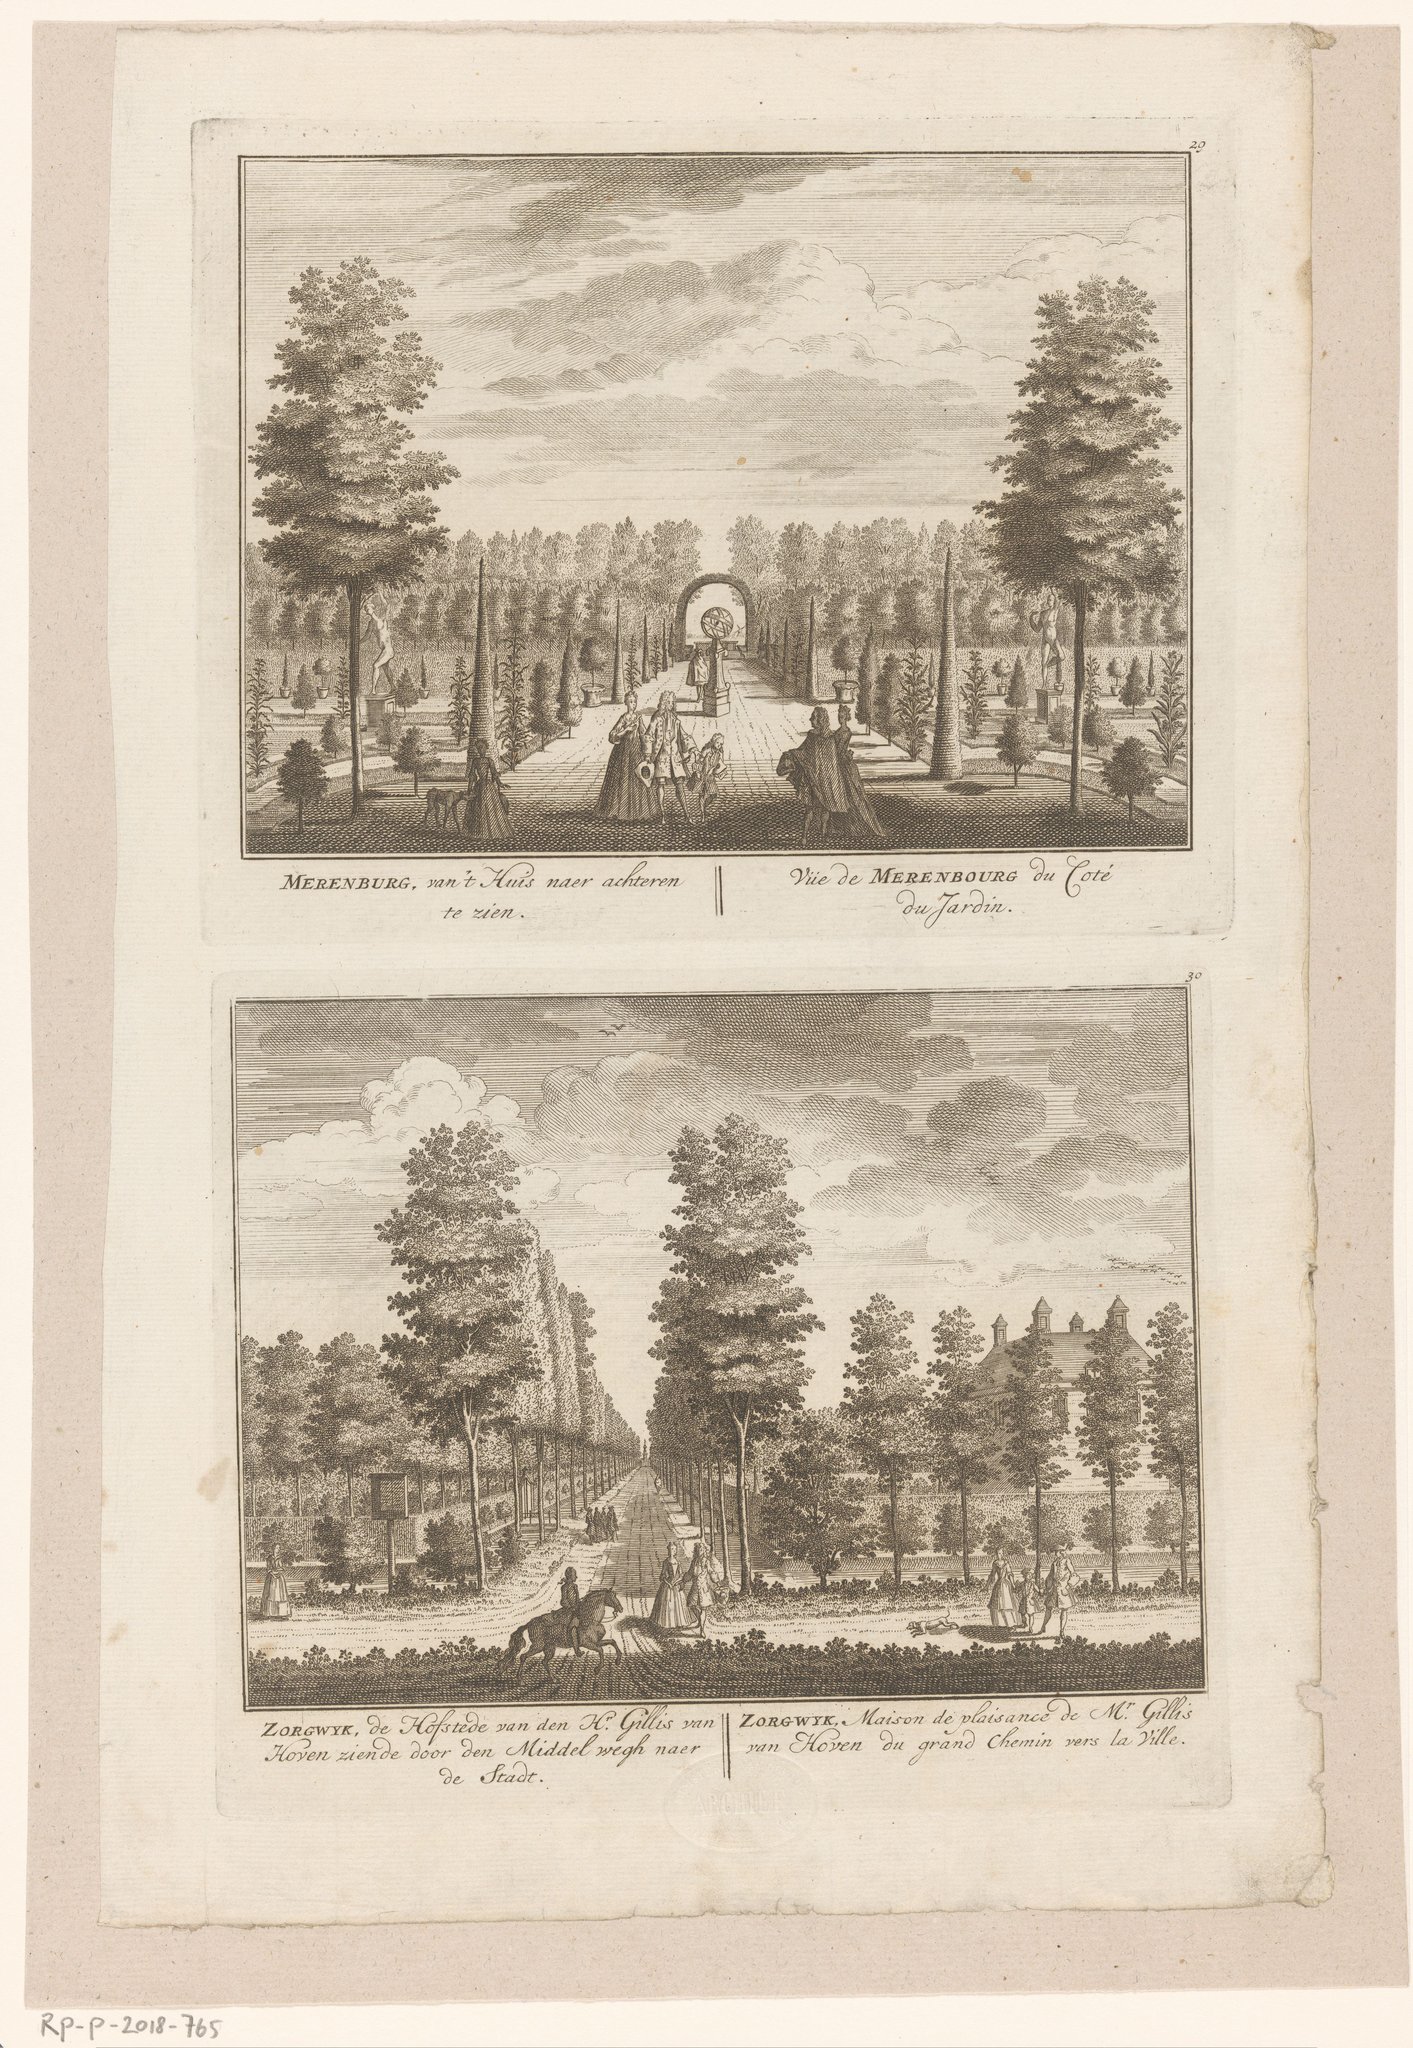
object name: book illustration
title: Merenburg, van 't huis naer achteren te zien / Vüe de Merenbourg du coté du jardin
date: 1725-1768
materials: paper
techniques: engraving, etching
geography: amsterdam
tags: french or architectonic garden; formal garden, public road, country-house, amsterdam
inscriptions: check stamp: ‘Archief Ministerie van Oorlog Afdeeling Genie’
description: Prent gebruikt in: Niedek, Mattaeus Brouërius. Het verheerlykt Watergraafs- of Diemermeer by de stadt Amsterdam (...). Amsterdam: Andries en Hendrik de Leth, 1725. Of in: Niedek, Mattaeus Brouërius. Het verheerlykt Watergraafs- of Diemermeer by de stadt Amsterdam (...). Amsterdam: Pieter Jan Entrop, 1768.